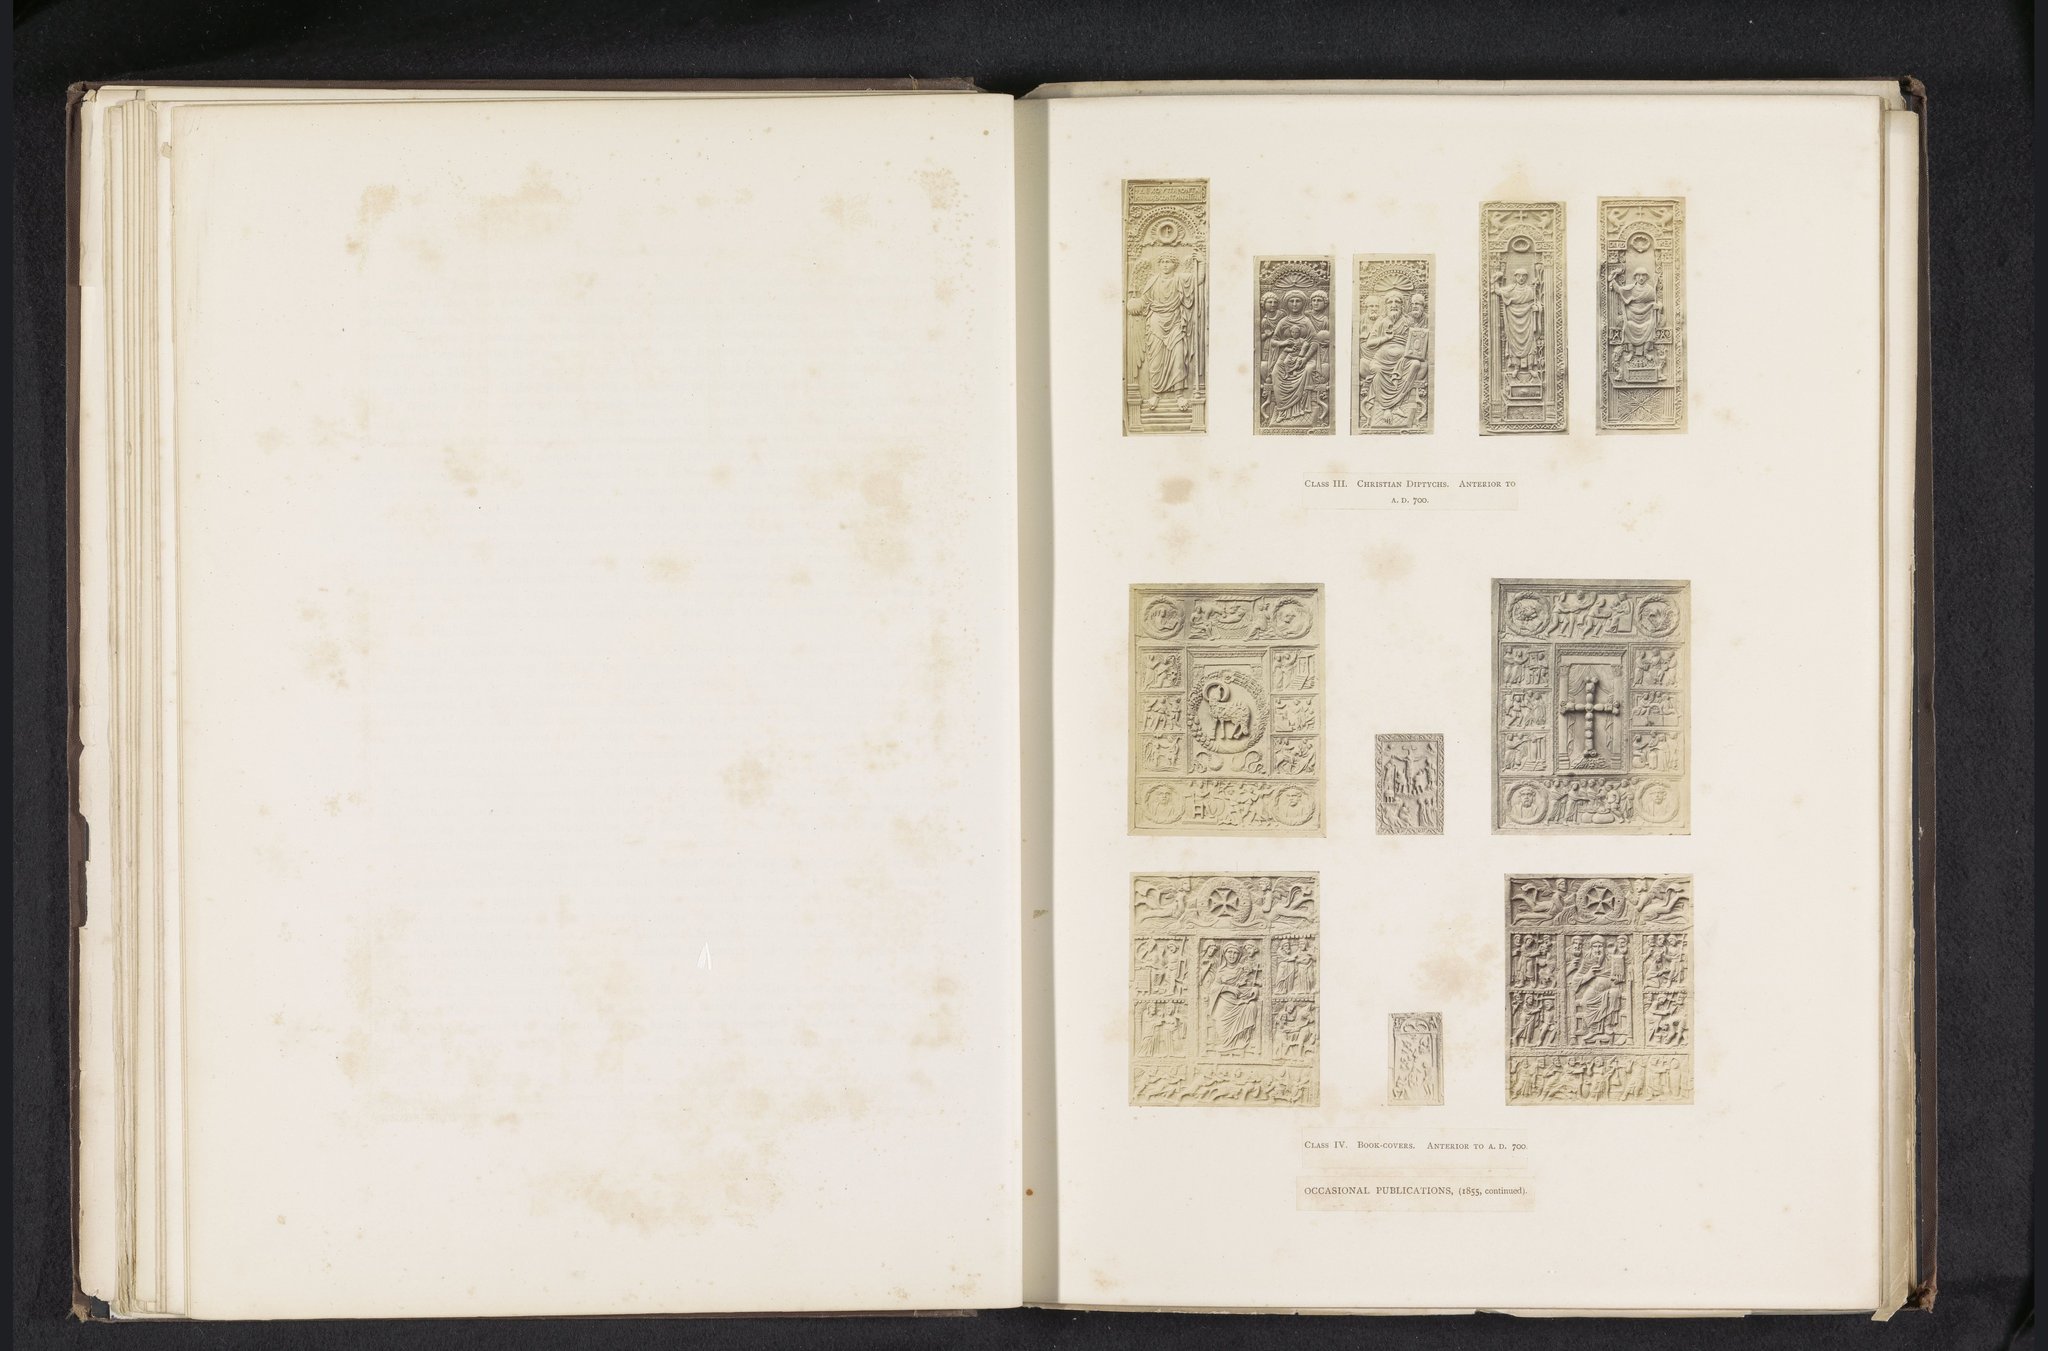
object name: page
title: Negentien fotoreproducties van een publicatie door de Arundel Society met christelijke ivoren reliëfs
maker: Anonymous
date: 1859-1869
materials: photographic support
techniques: albumen print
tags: book, sculpture (+ relief ~ sculpture)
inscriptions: inscription: ‘Class III. Christian diptychs. (...) occasional publications, (1855, continued).’